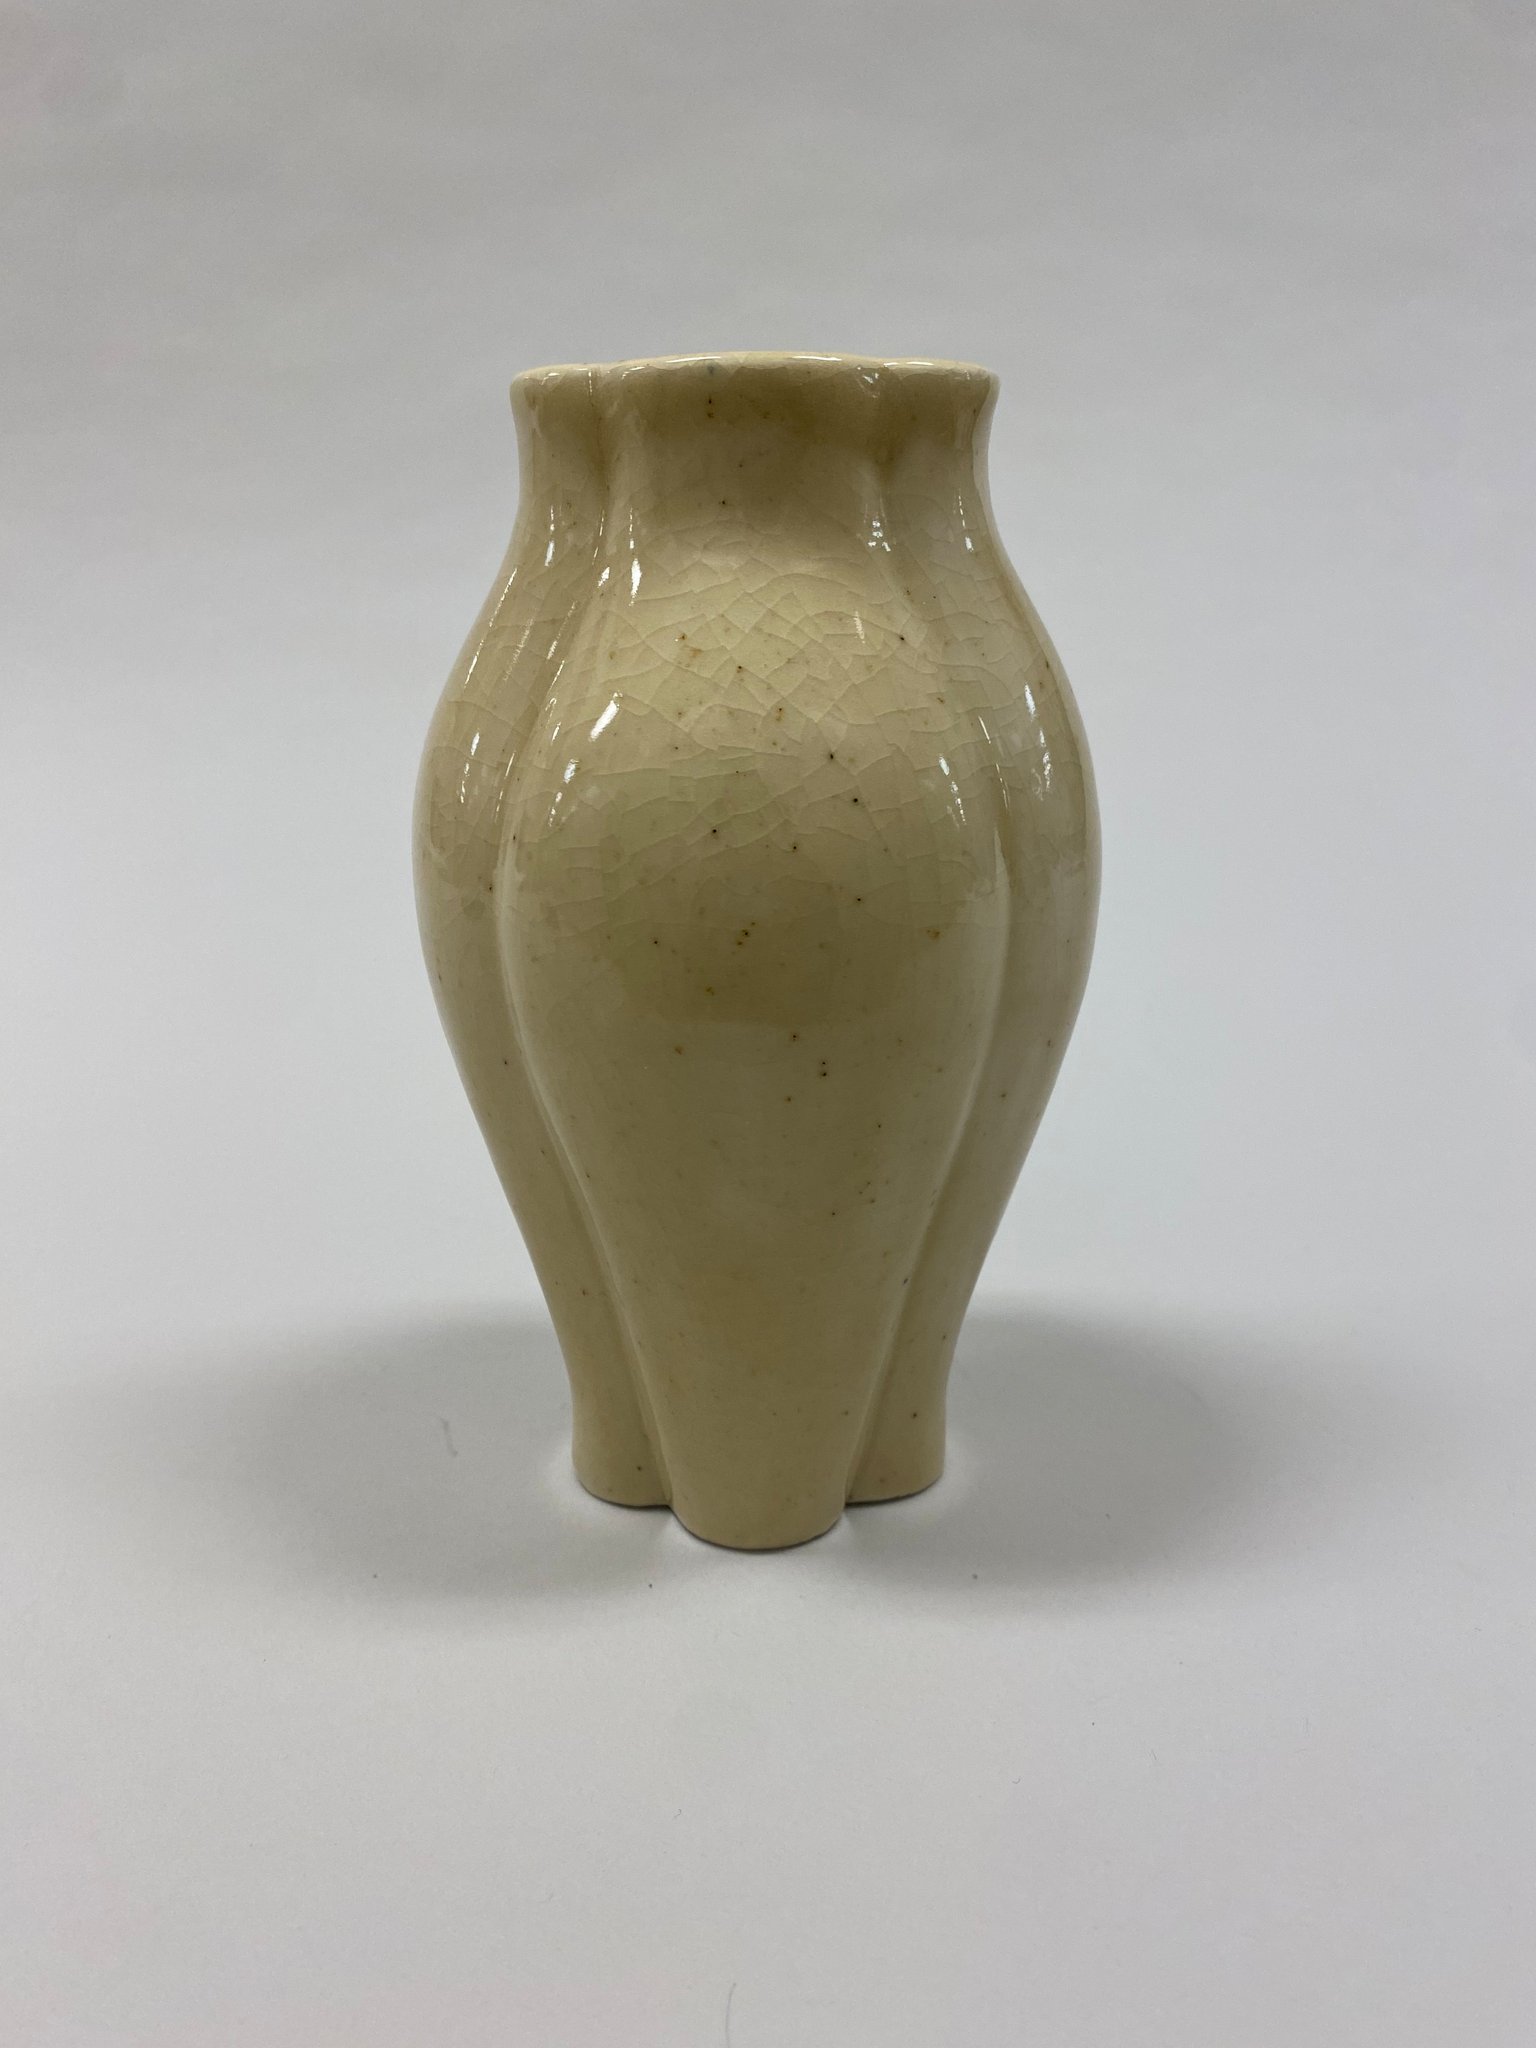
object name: vase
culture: chinese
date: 1801-1900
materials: glaze, porcelain